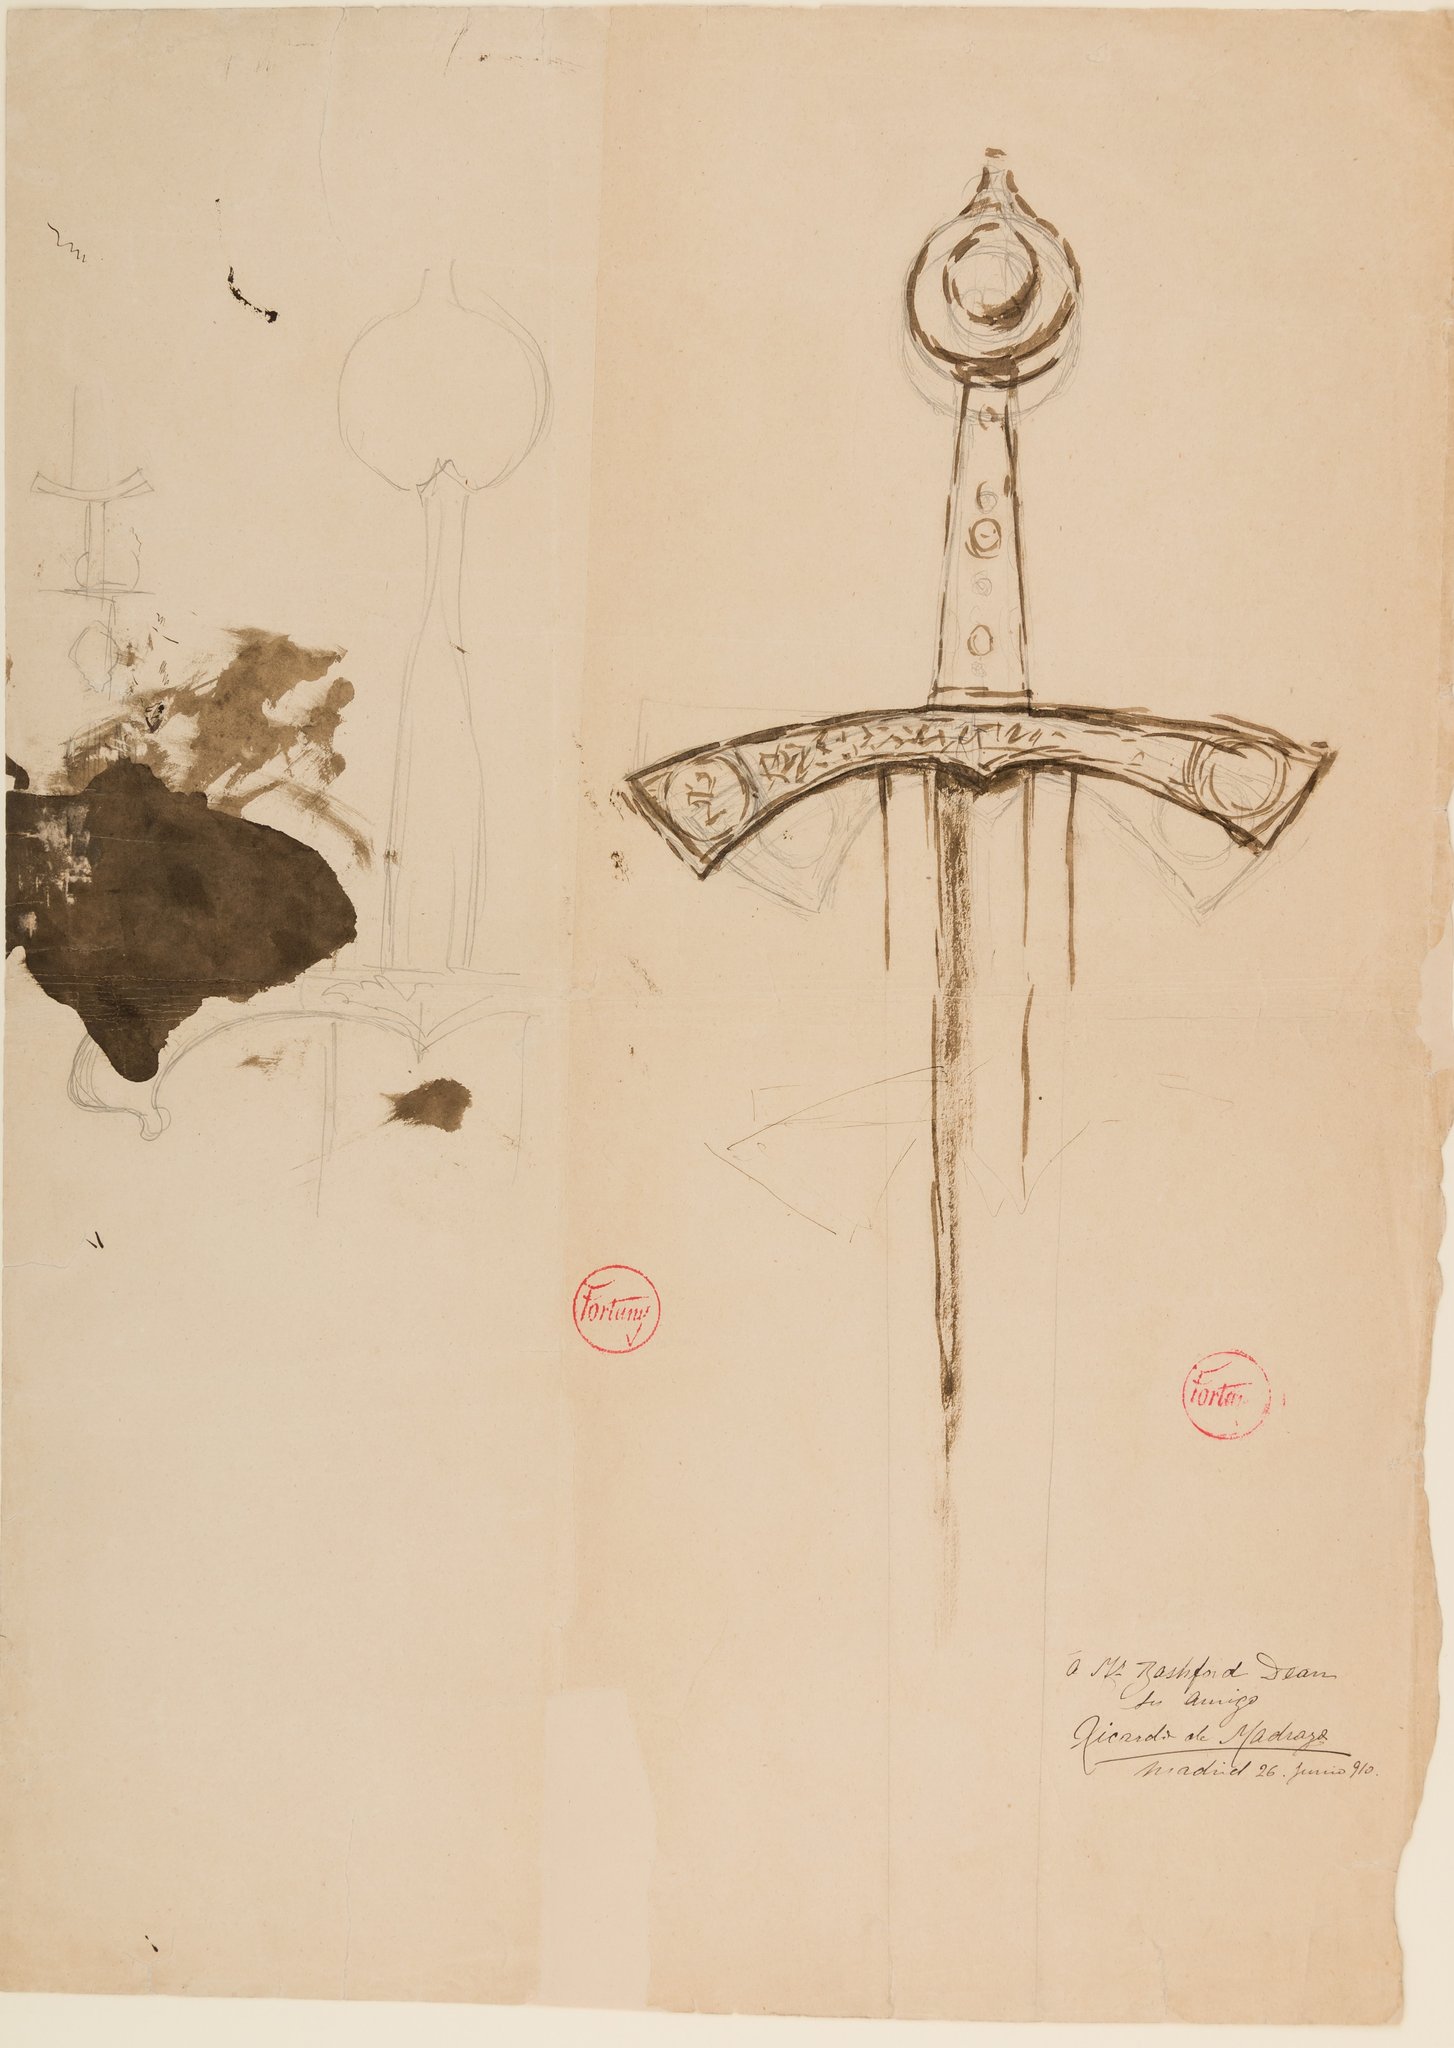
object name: drawing of two medieval sword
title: Drawing of Two Medieval Swords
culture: spanish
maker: mariano fortuny, 1838–1874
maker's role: artist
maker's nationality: spanish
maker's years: 1838-1874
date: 1801-1900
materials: graphite, ink, paper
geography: spain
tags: swords